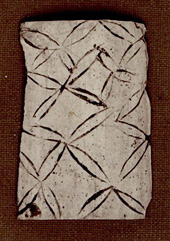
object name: inlay from toilet box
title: Inlay from box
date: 1981-1640 BCE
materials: ivory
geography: egypt